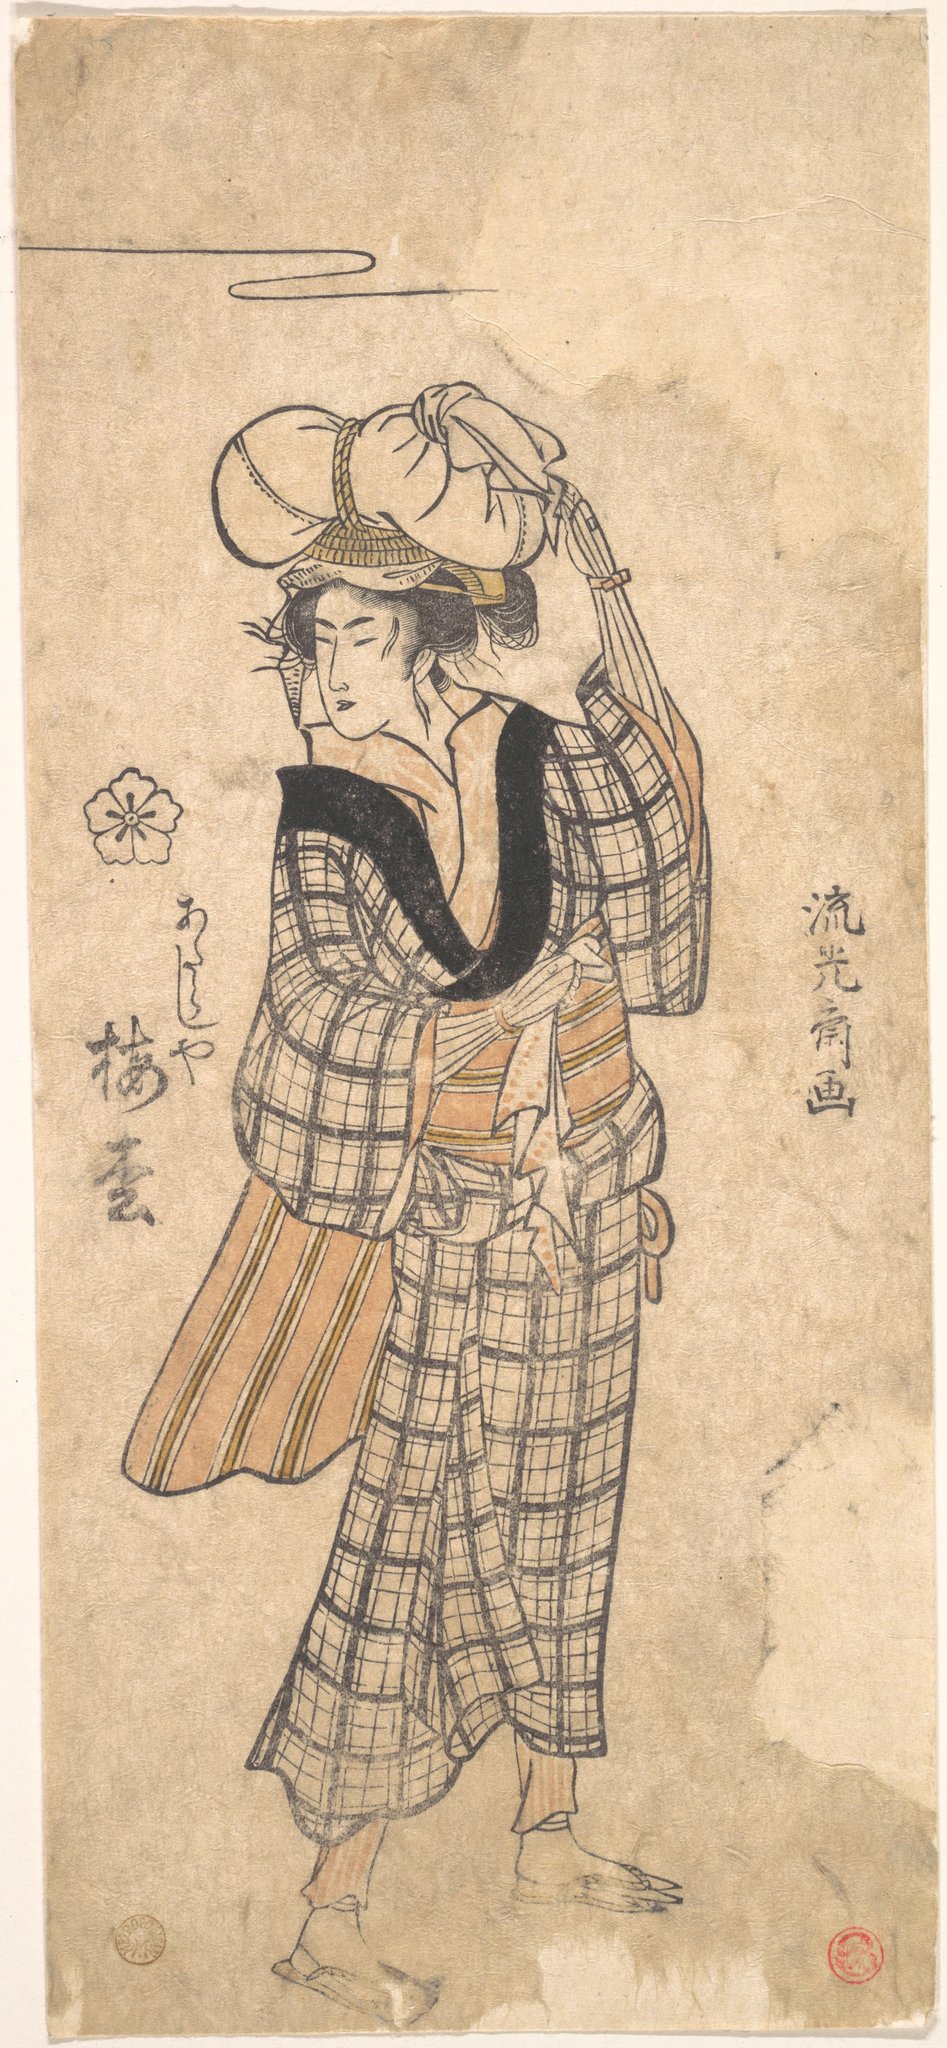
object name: woodblock print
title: The Courtesan Umematsu of the Atarashiya Brothel Costumed as an Ohara Maiden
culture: japanese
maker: ryūkōsai jokei 流光斎如圭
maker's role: artist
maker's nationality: japanese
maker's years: 1777-1809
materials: ink, paper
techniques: woodblock print, nishiki e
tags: women